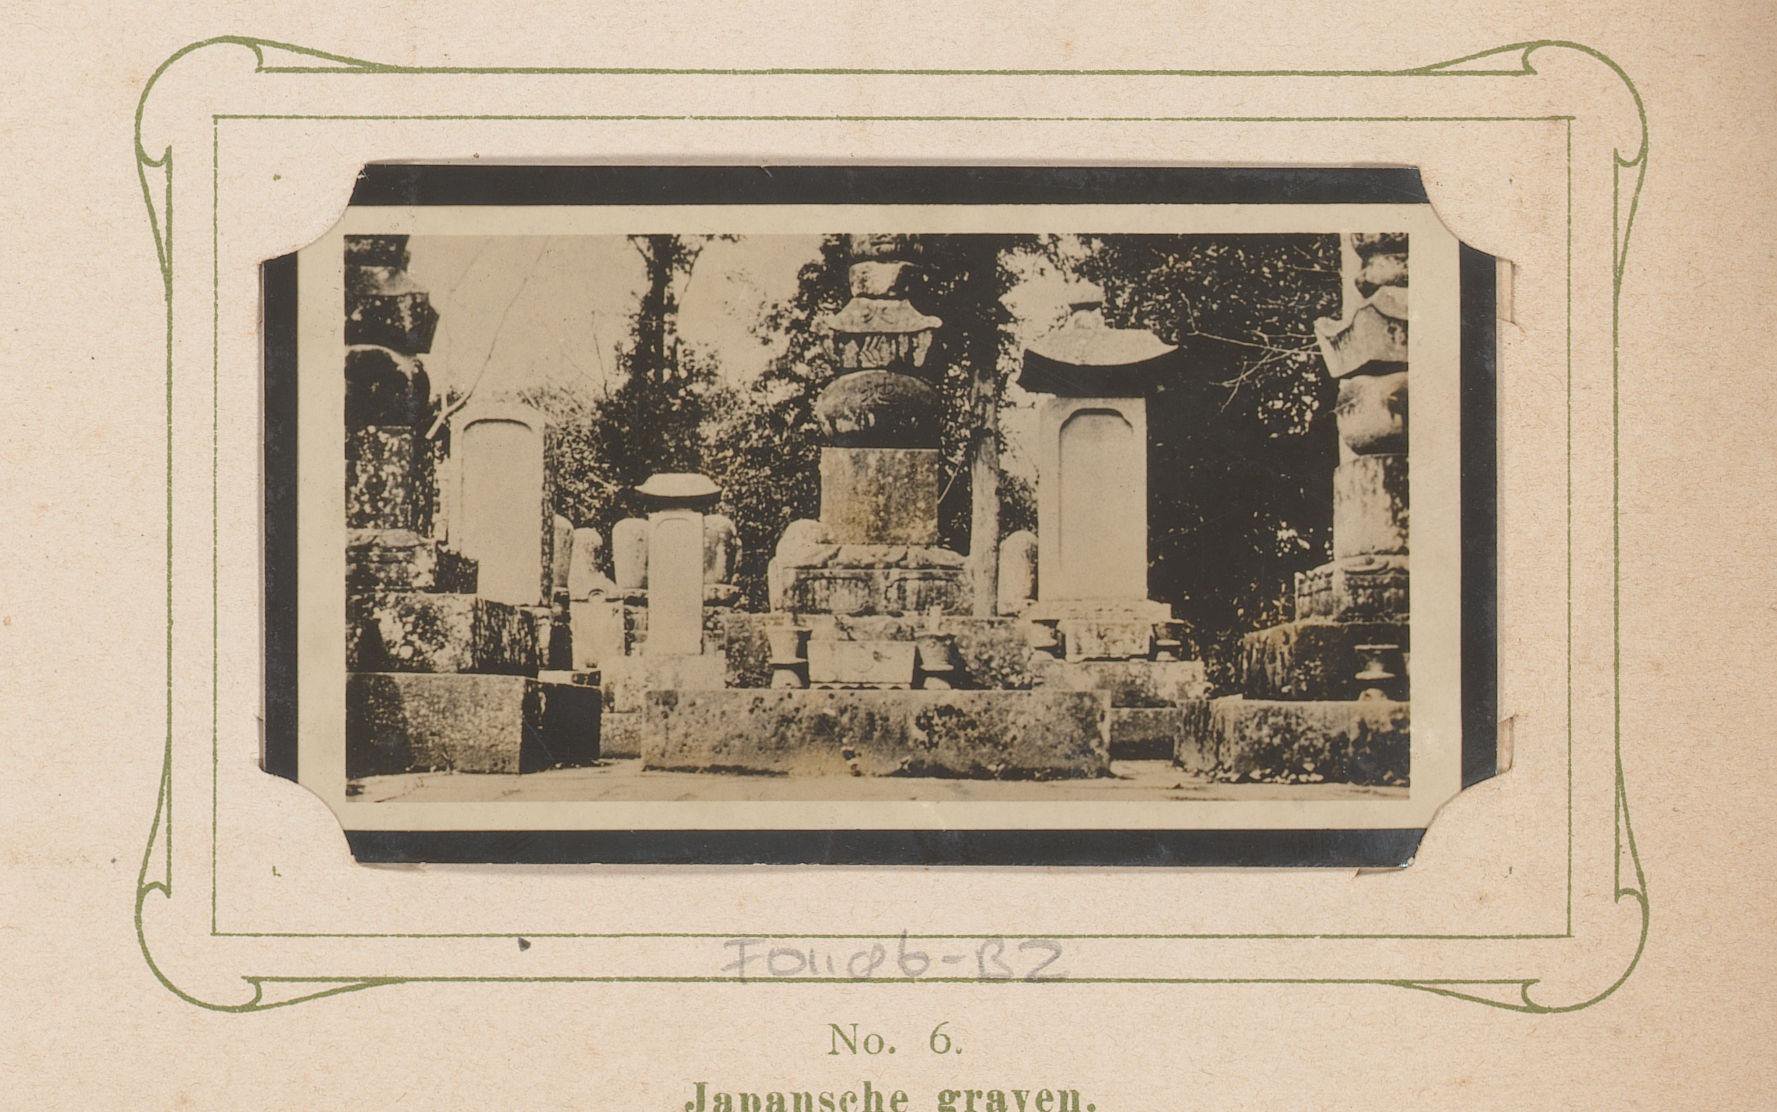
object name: photograph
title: Japanse graven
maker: Anonymous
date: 1904-1905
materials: photographic support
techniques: gelatin silver print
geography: japan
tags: grave, tomb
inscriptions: inscription: ‘No. 6./ Japansche graven.’